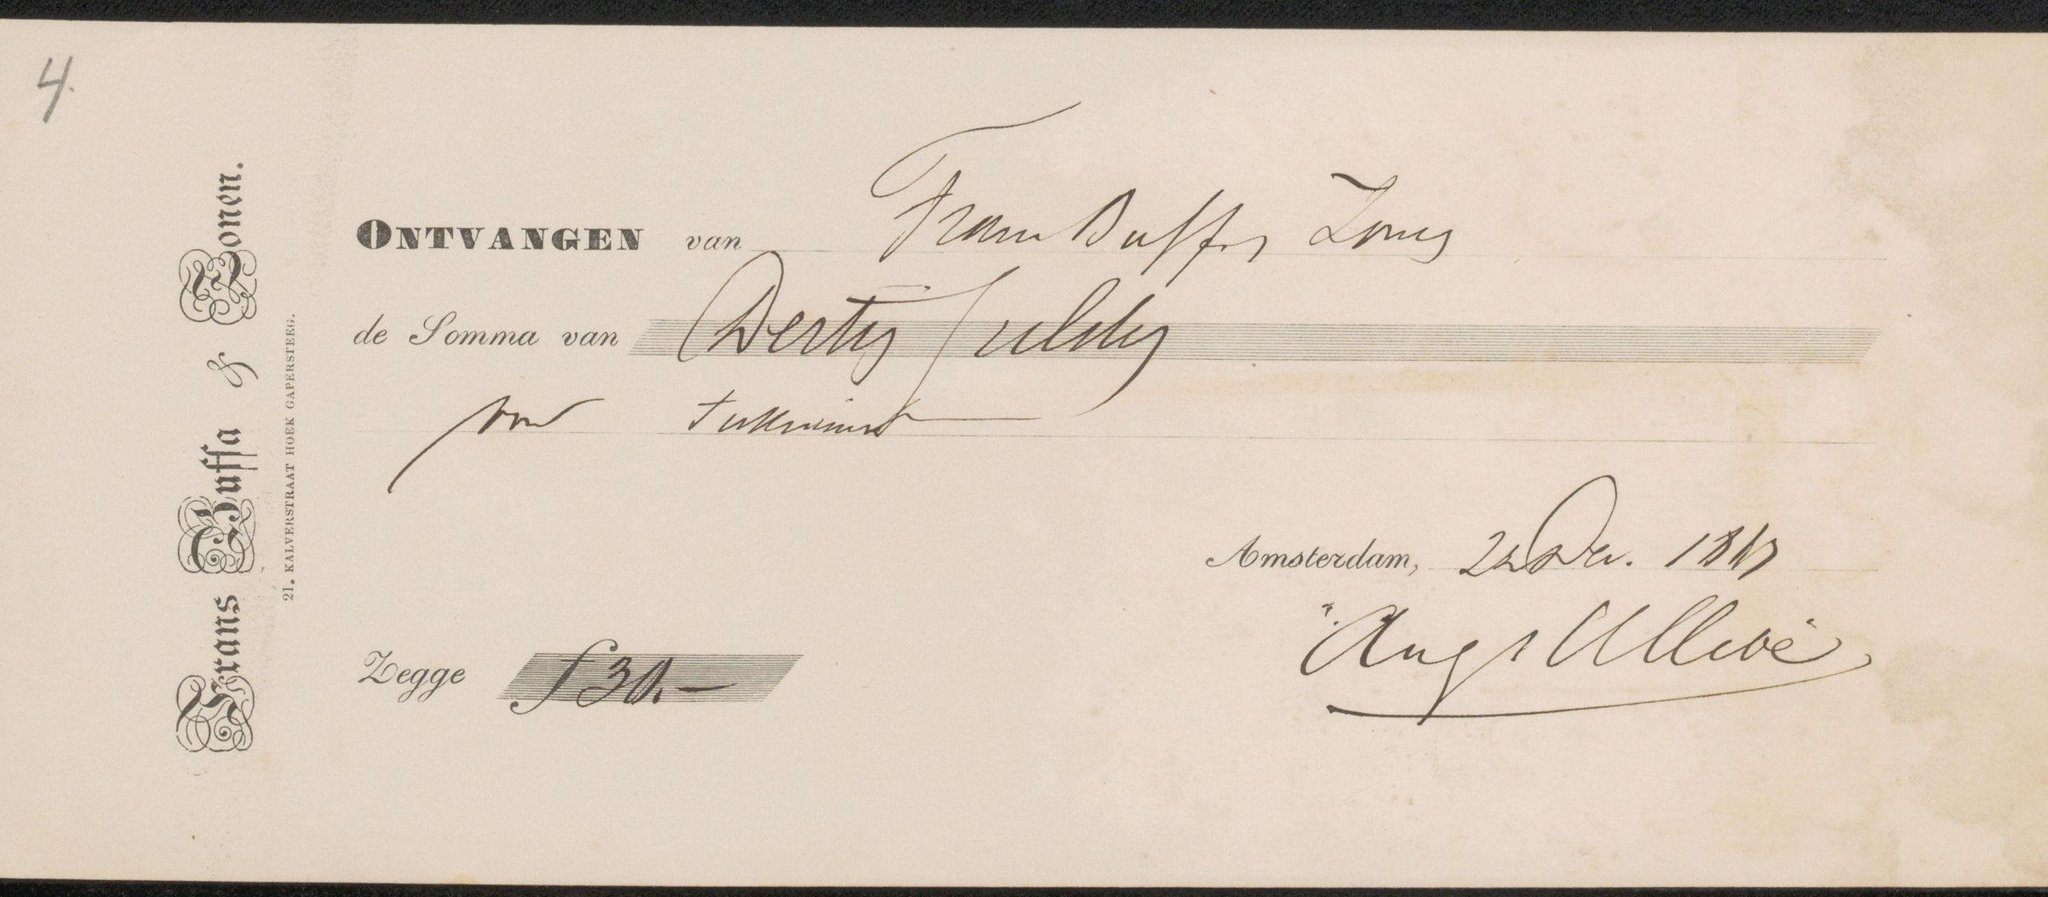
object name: ontvangstbewijs, kwitantie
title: Kwitantie voor August Allebé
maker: august allebé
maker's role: draughtsman, print maker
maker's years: 1838-1927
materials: ink, paper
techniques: pen, printing, writing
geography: amsterdam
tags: art trade, art shop, drawing, money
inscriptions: collector's mark: Lugt 2233